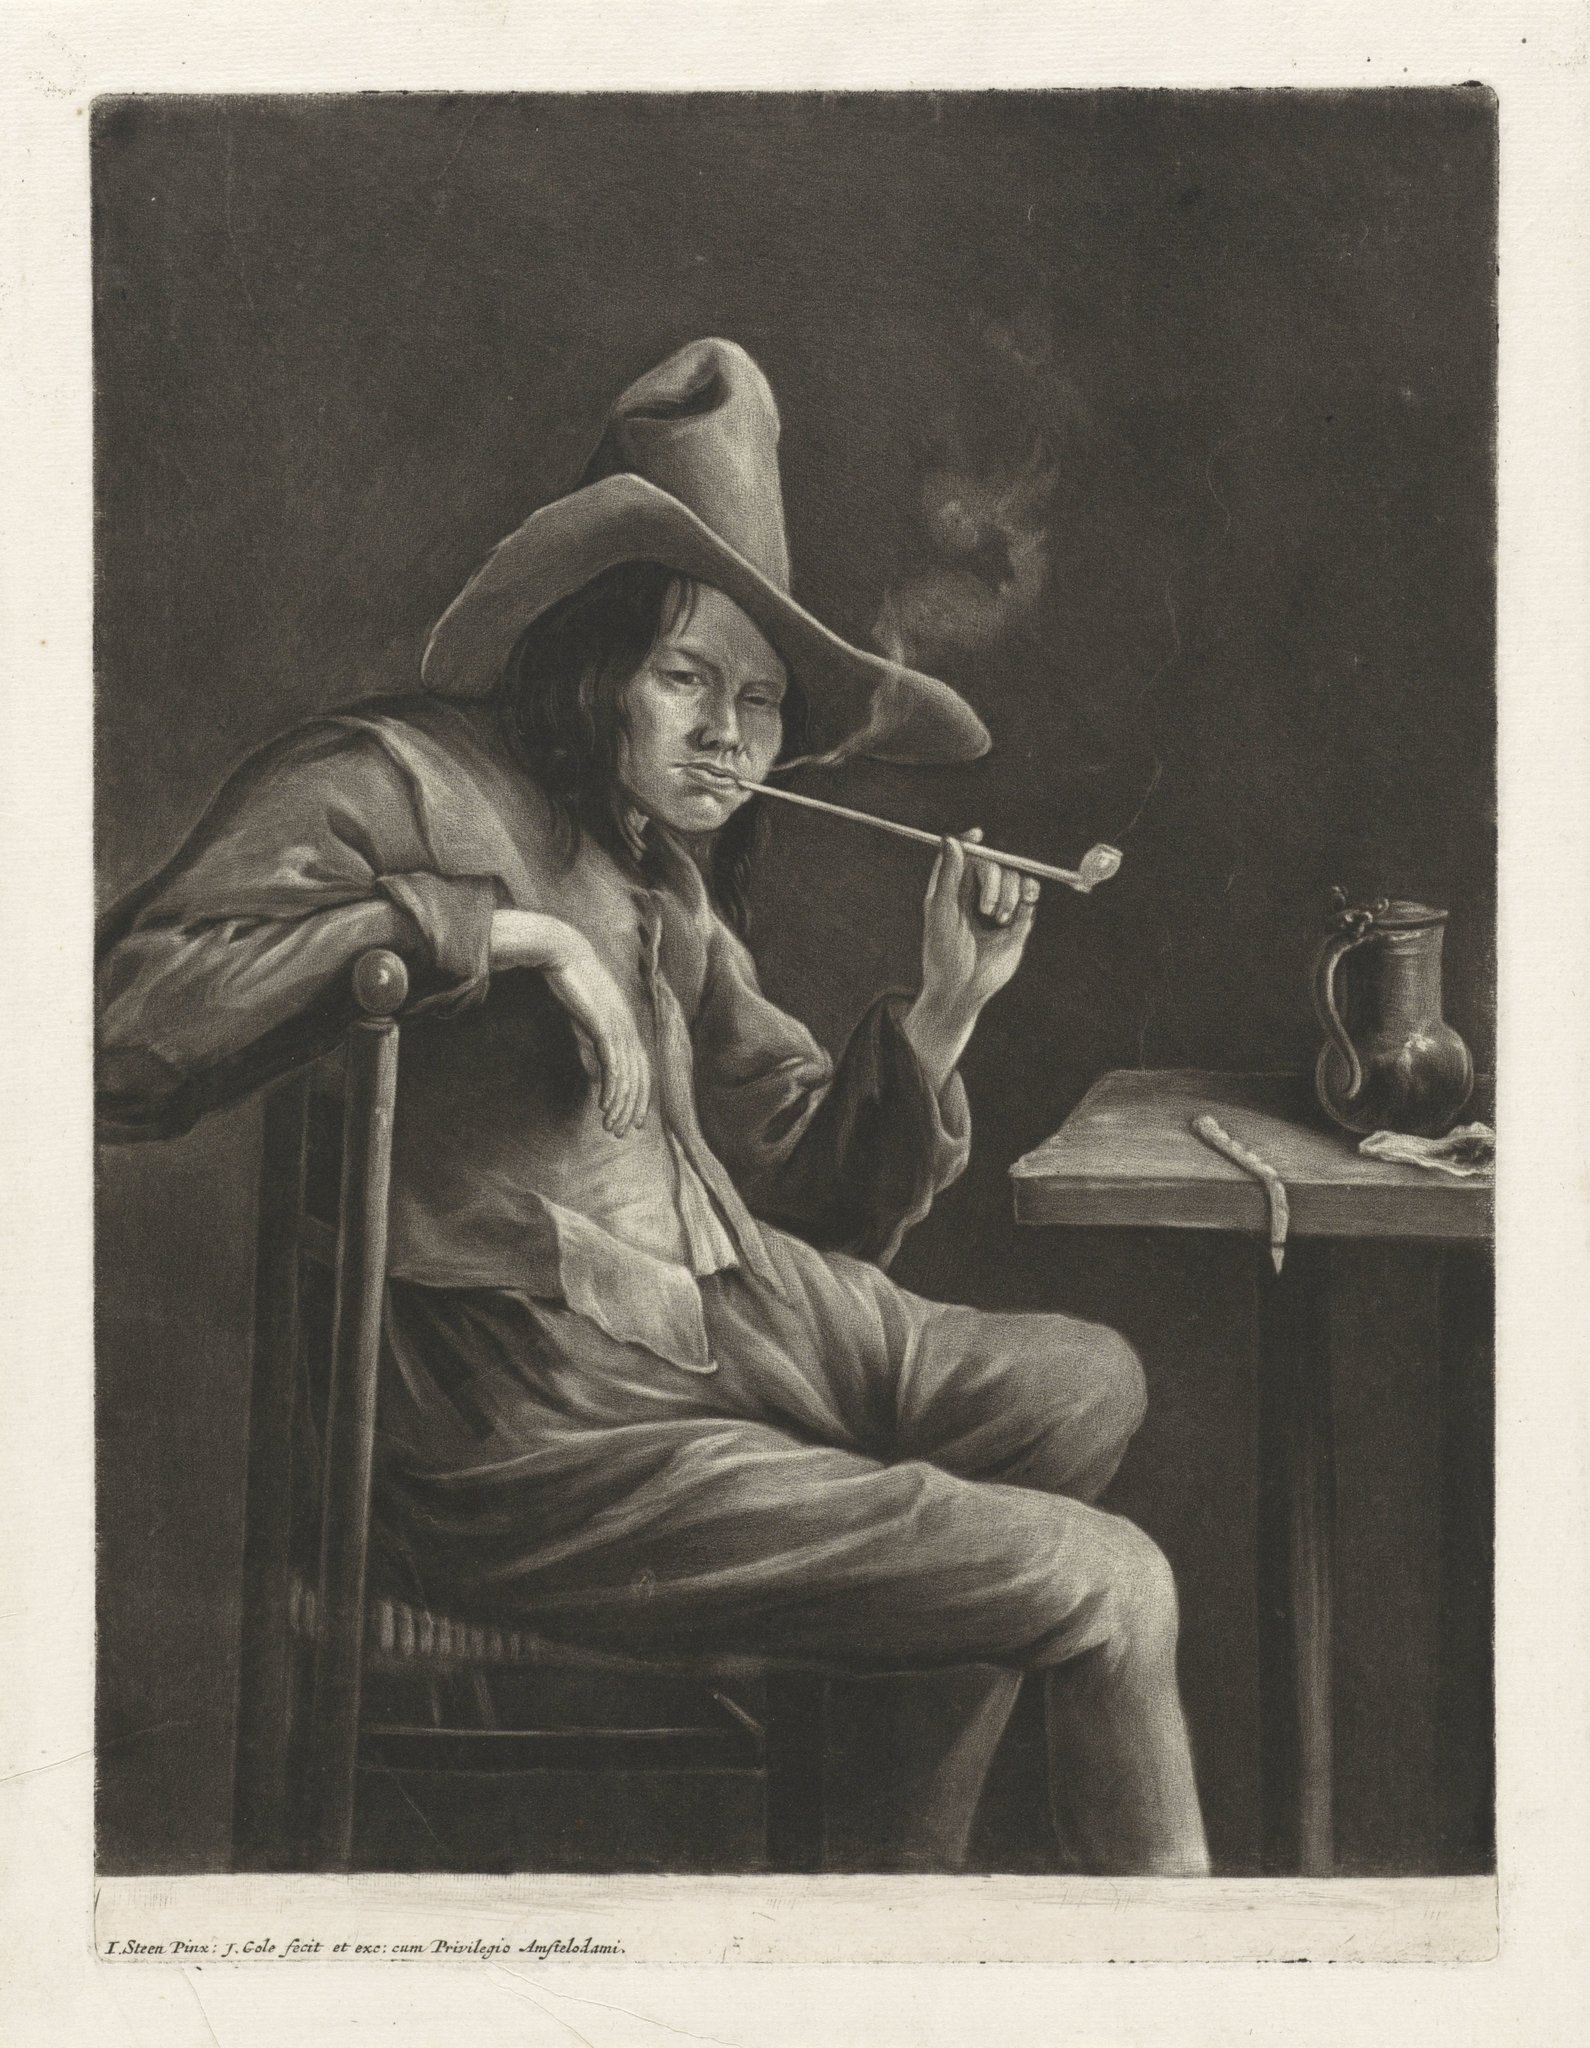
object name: print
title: De vijf zintuigen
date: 1670-1724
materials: paper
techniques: engraving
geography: amsterdam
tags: smell, smelling (one of the five senses), pipe ~ tobacco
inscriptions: collector's mark: Lugt 240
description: Het zintuig Reuk. Een man rookt een pijp en blaast rook uit. De prent maakt deel uit van een serie met de vijf zintuigen.